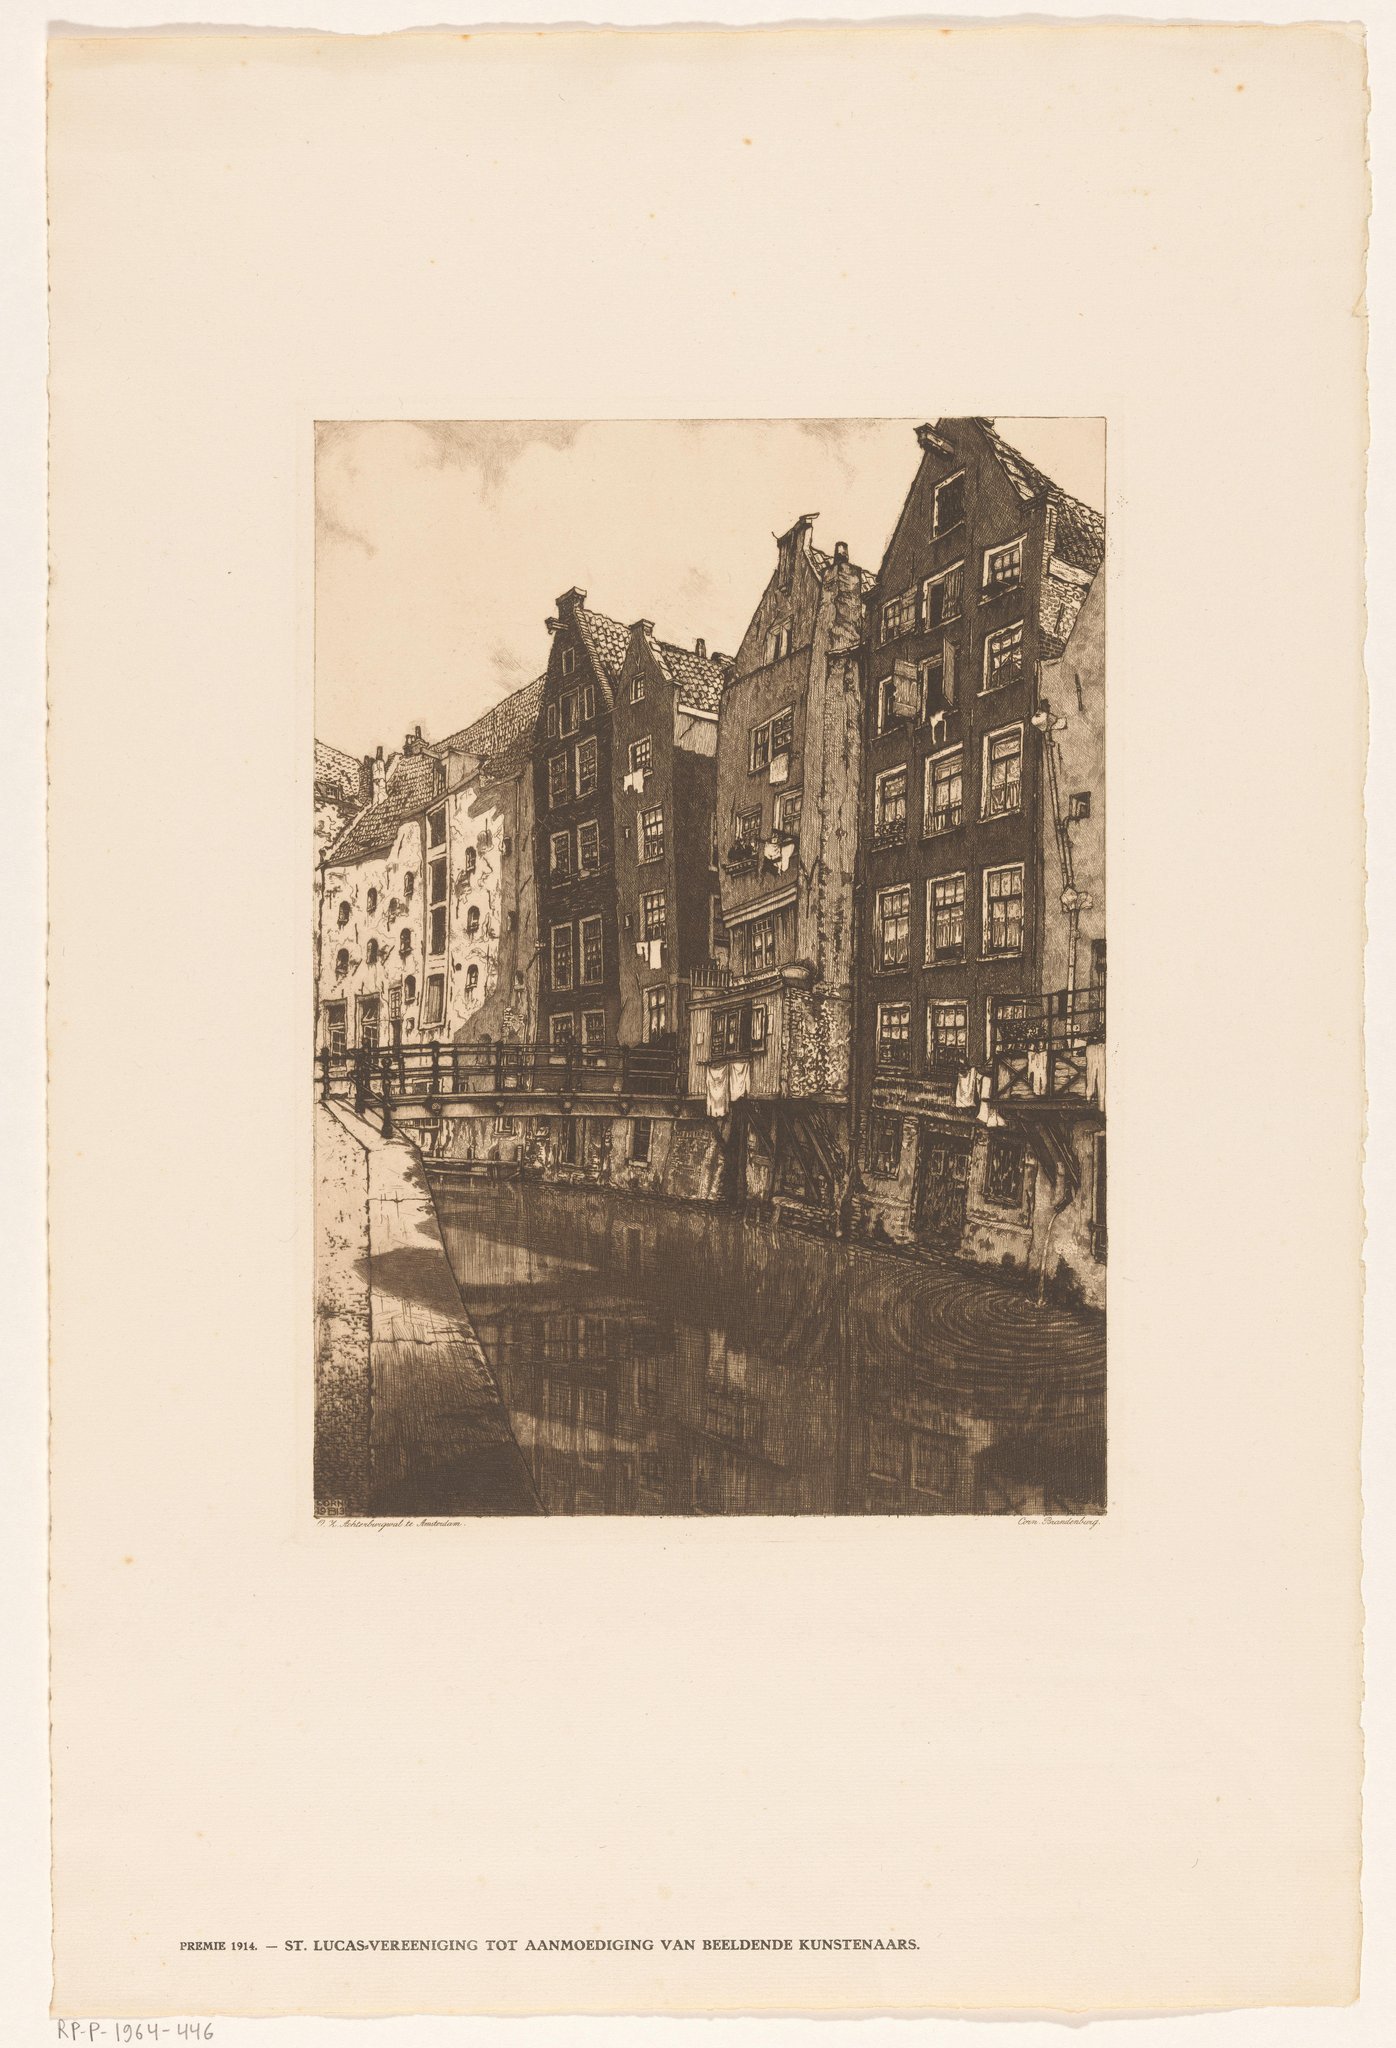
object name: print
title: Oudezijds Achterburgwal te Amsterdam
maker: cornelis brandenburg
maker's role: print maker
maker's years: 1884-1954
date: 1913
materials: paper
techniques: etching, intaglio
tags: urban housing, bridge in city across river, canal, etc.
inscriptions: collector's mark: Lugt 2228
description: Huizen aan, en een brug over, het water van de Oudezijds Achterburgwal.